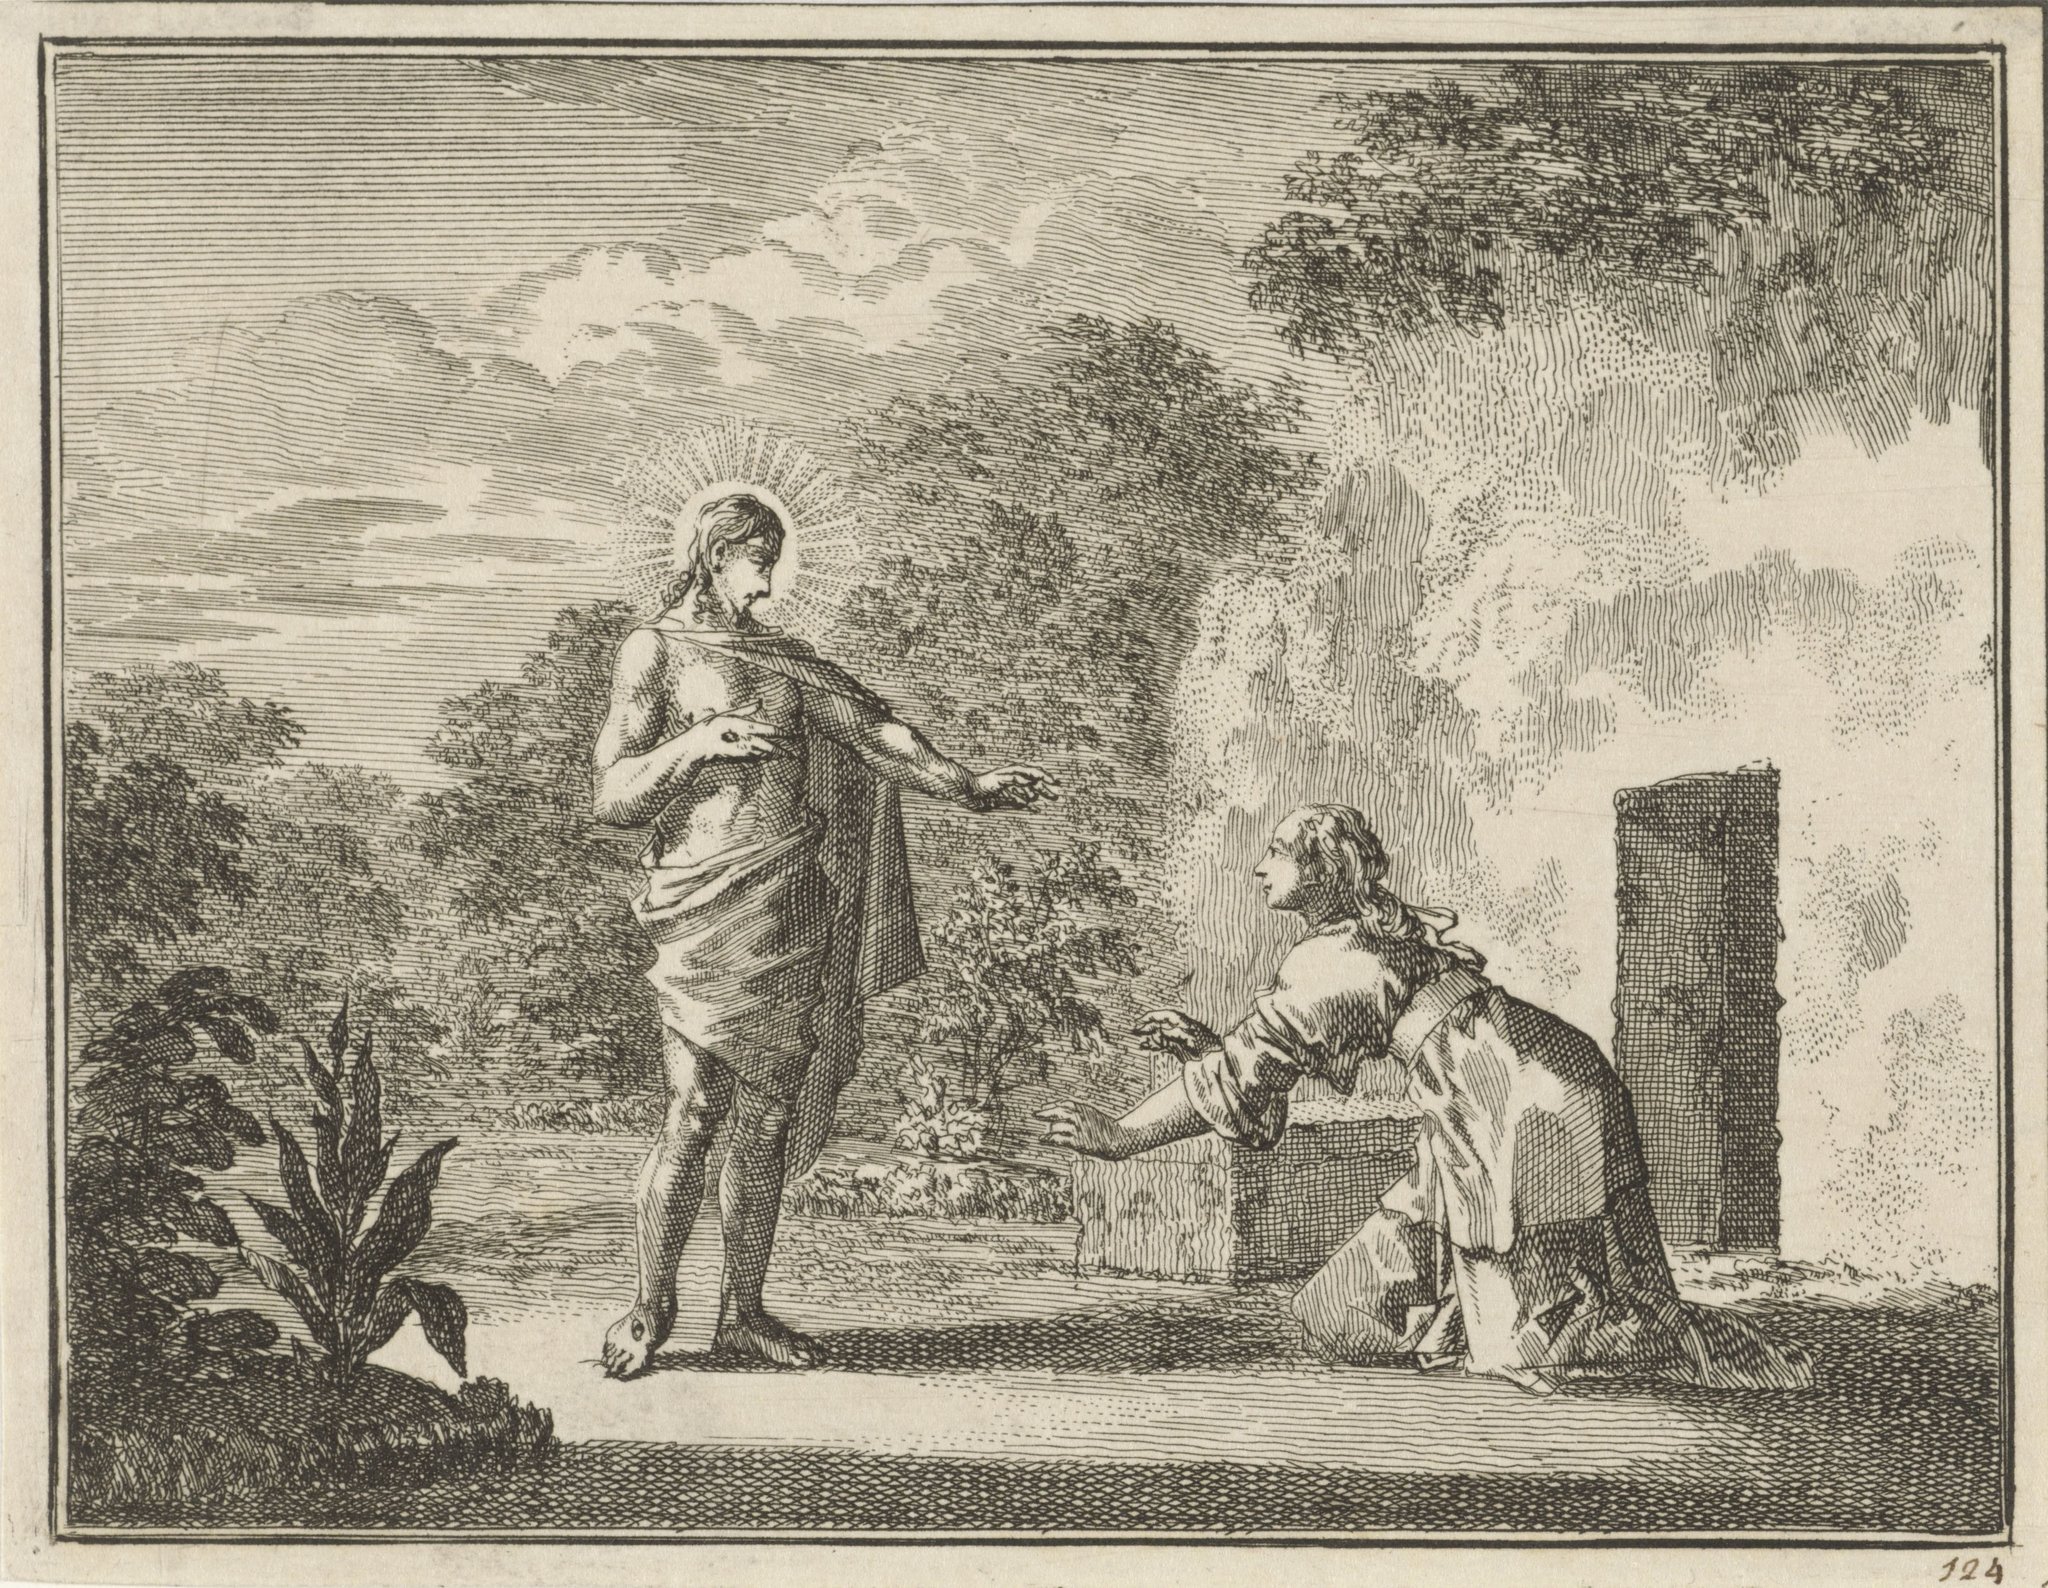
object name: print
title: Christus verschijnt aan Maria Magdalena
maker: jan luyken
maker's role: draughtsman, print maker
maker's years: 1649-1712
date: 1712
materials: paper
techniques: etching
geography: amsterdam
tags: mary magdalene kneeling before christ, who is usually represented as a gardener with a hoe and/or a spade; 'noli me tangere'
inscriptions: number: ‘124’, collector's mark: Lugt 2228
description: Proefdruk van illustratie uit: Luyken, Jan. De schriftuurlyke geschiedenissen en gelykenissen van het Oude en Nieuwe Verbond, 2 delen. Amsterdam: Wed. Pieter Arentsz II en Cornelis van der Sys, 1712, dl. II.